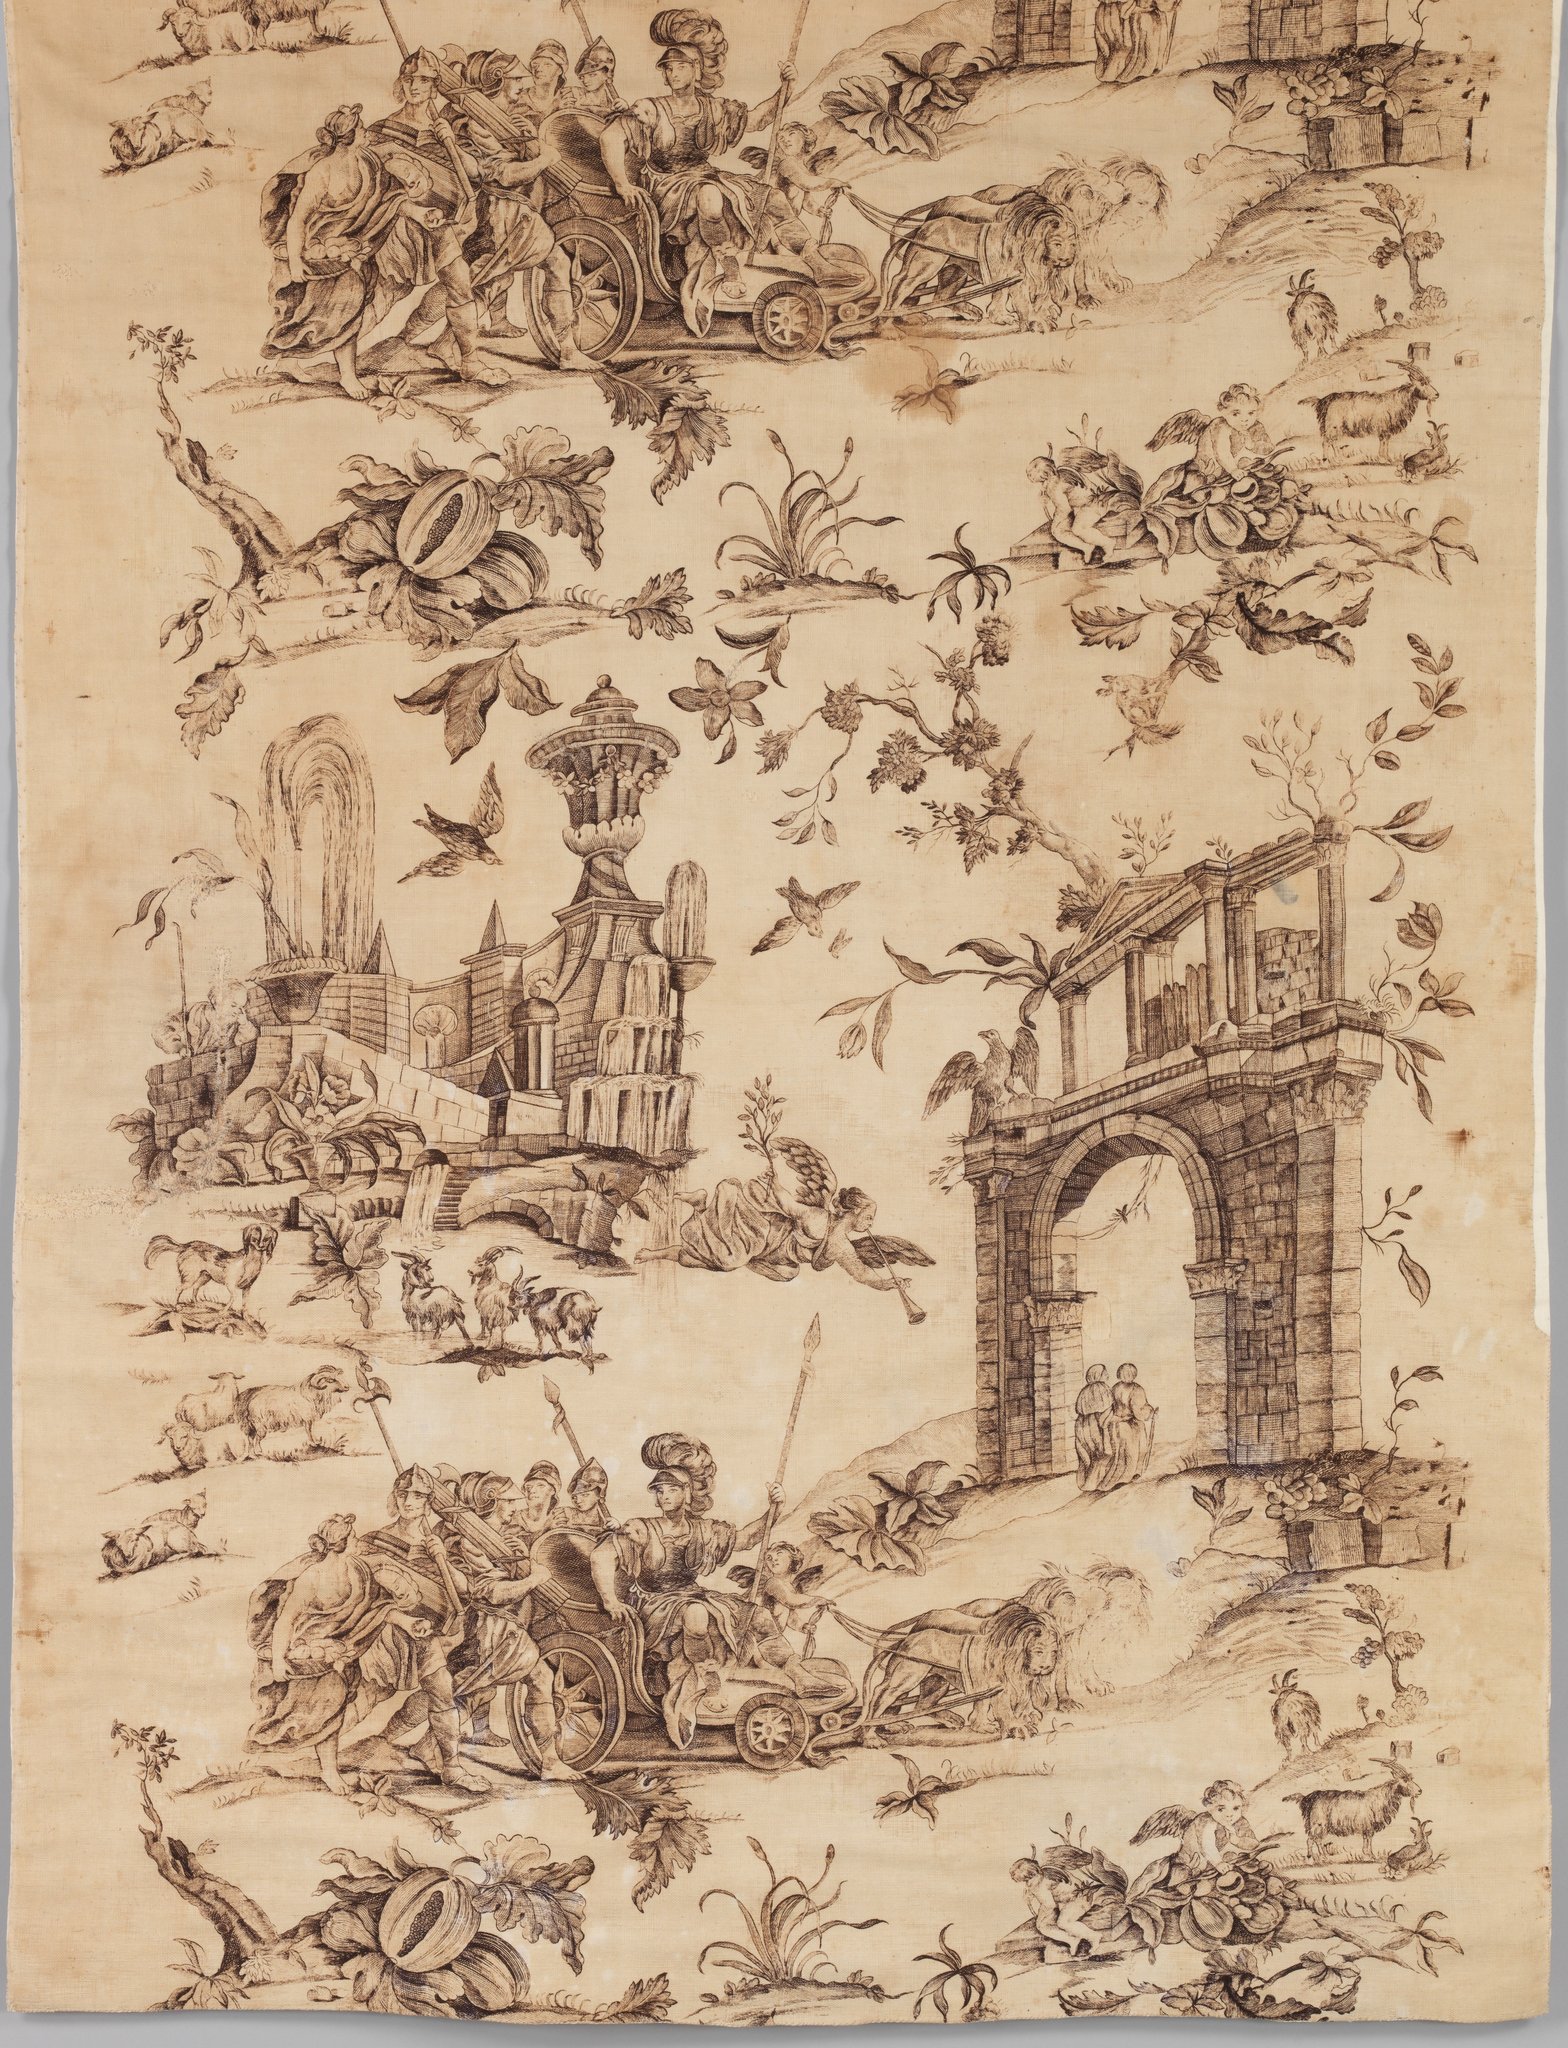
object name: piece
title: Piece with Roman chariot and ruins (Furnishing fabric)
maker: bromley hall printworks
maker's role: manufactory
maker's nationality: english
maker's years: 1694-1823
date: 1770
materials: cotton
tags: birds,men,women,goats,lions,chariots